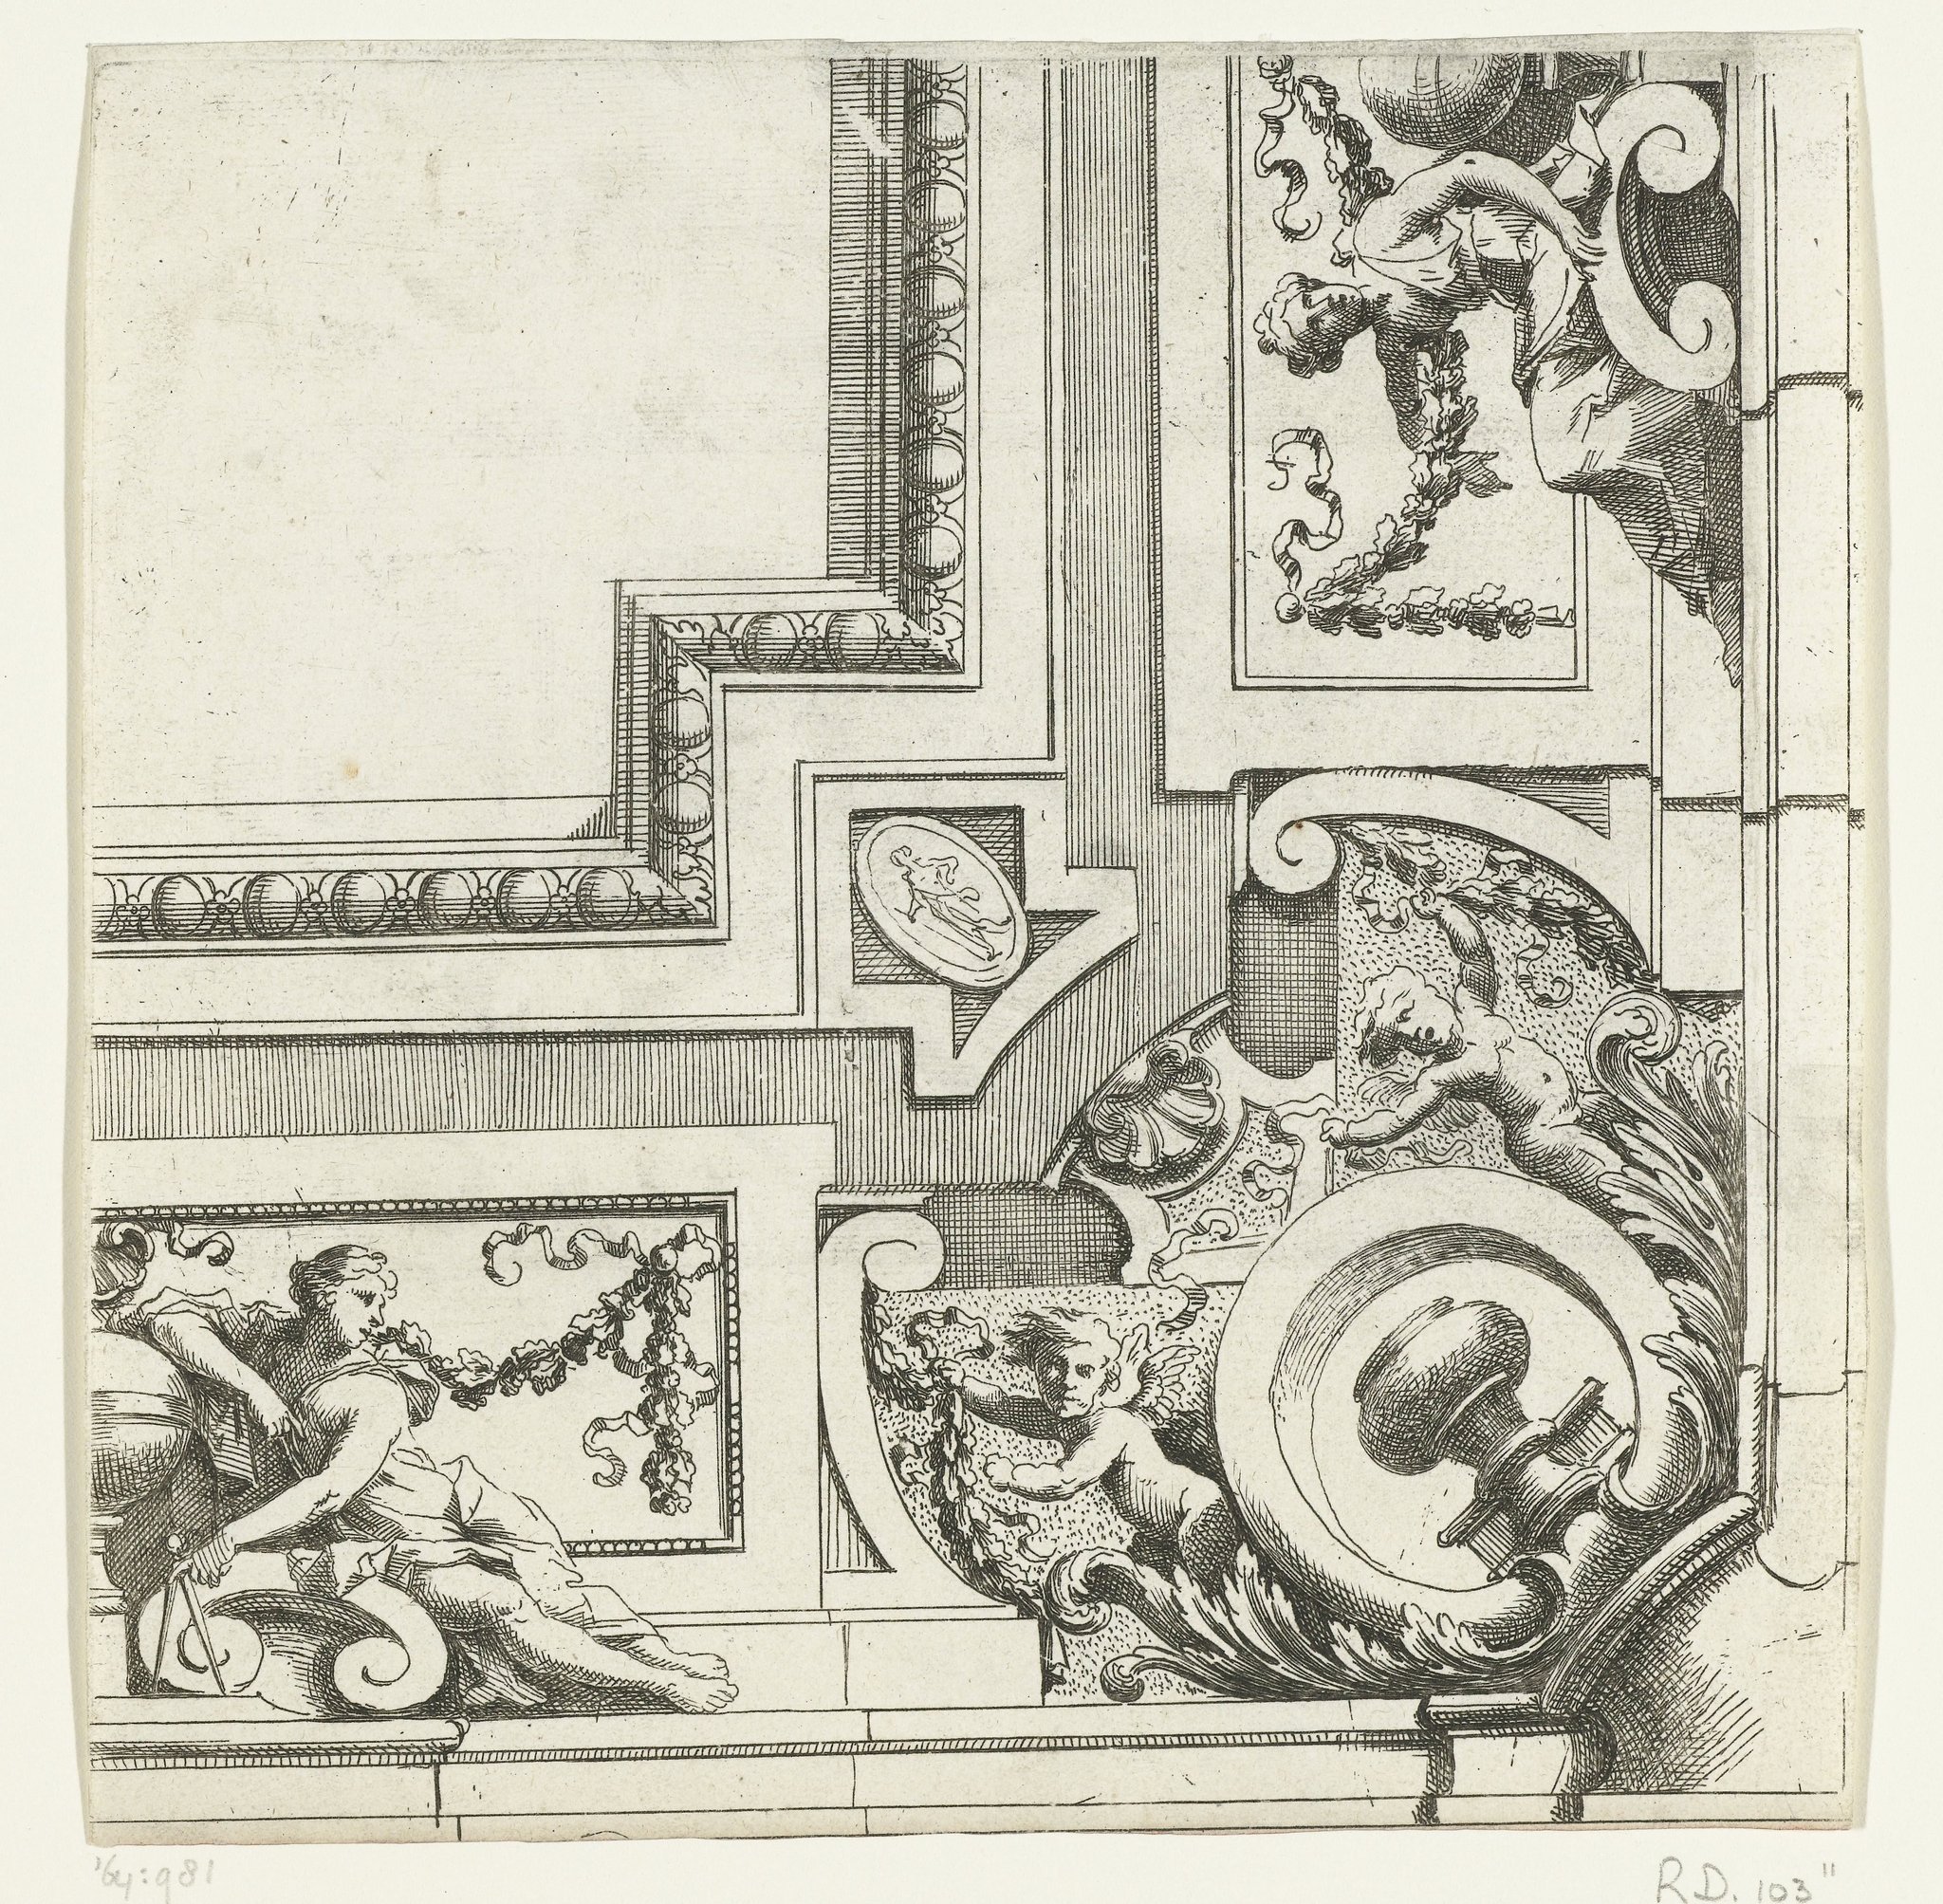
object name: ornament print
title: Kwart van vierkant plafond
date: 1634-1716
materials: paper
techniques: etching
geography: france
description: In het midden een leeg vlak, de randen zijn gedecoreerd met een vrouw naast een bol. Blad 8 uit serie van 12, tweede editie.